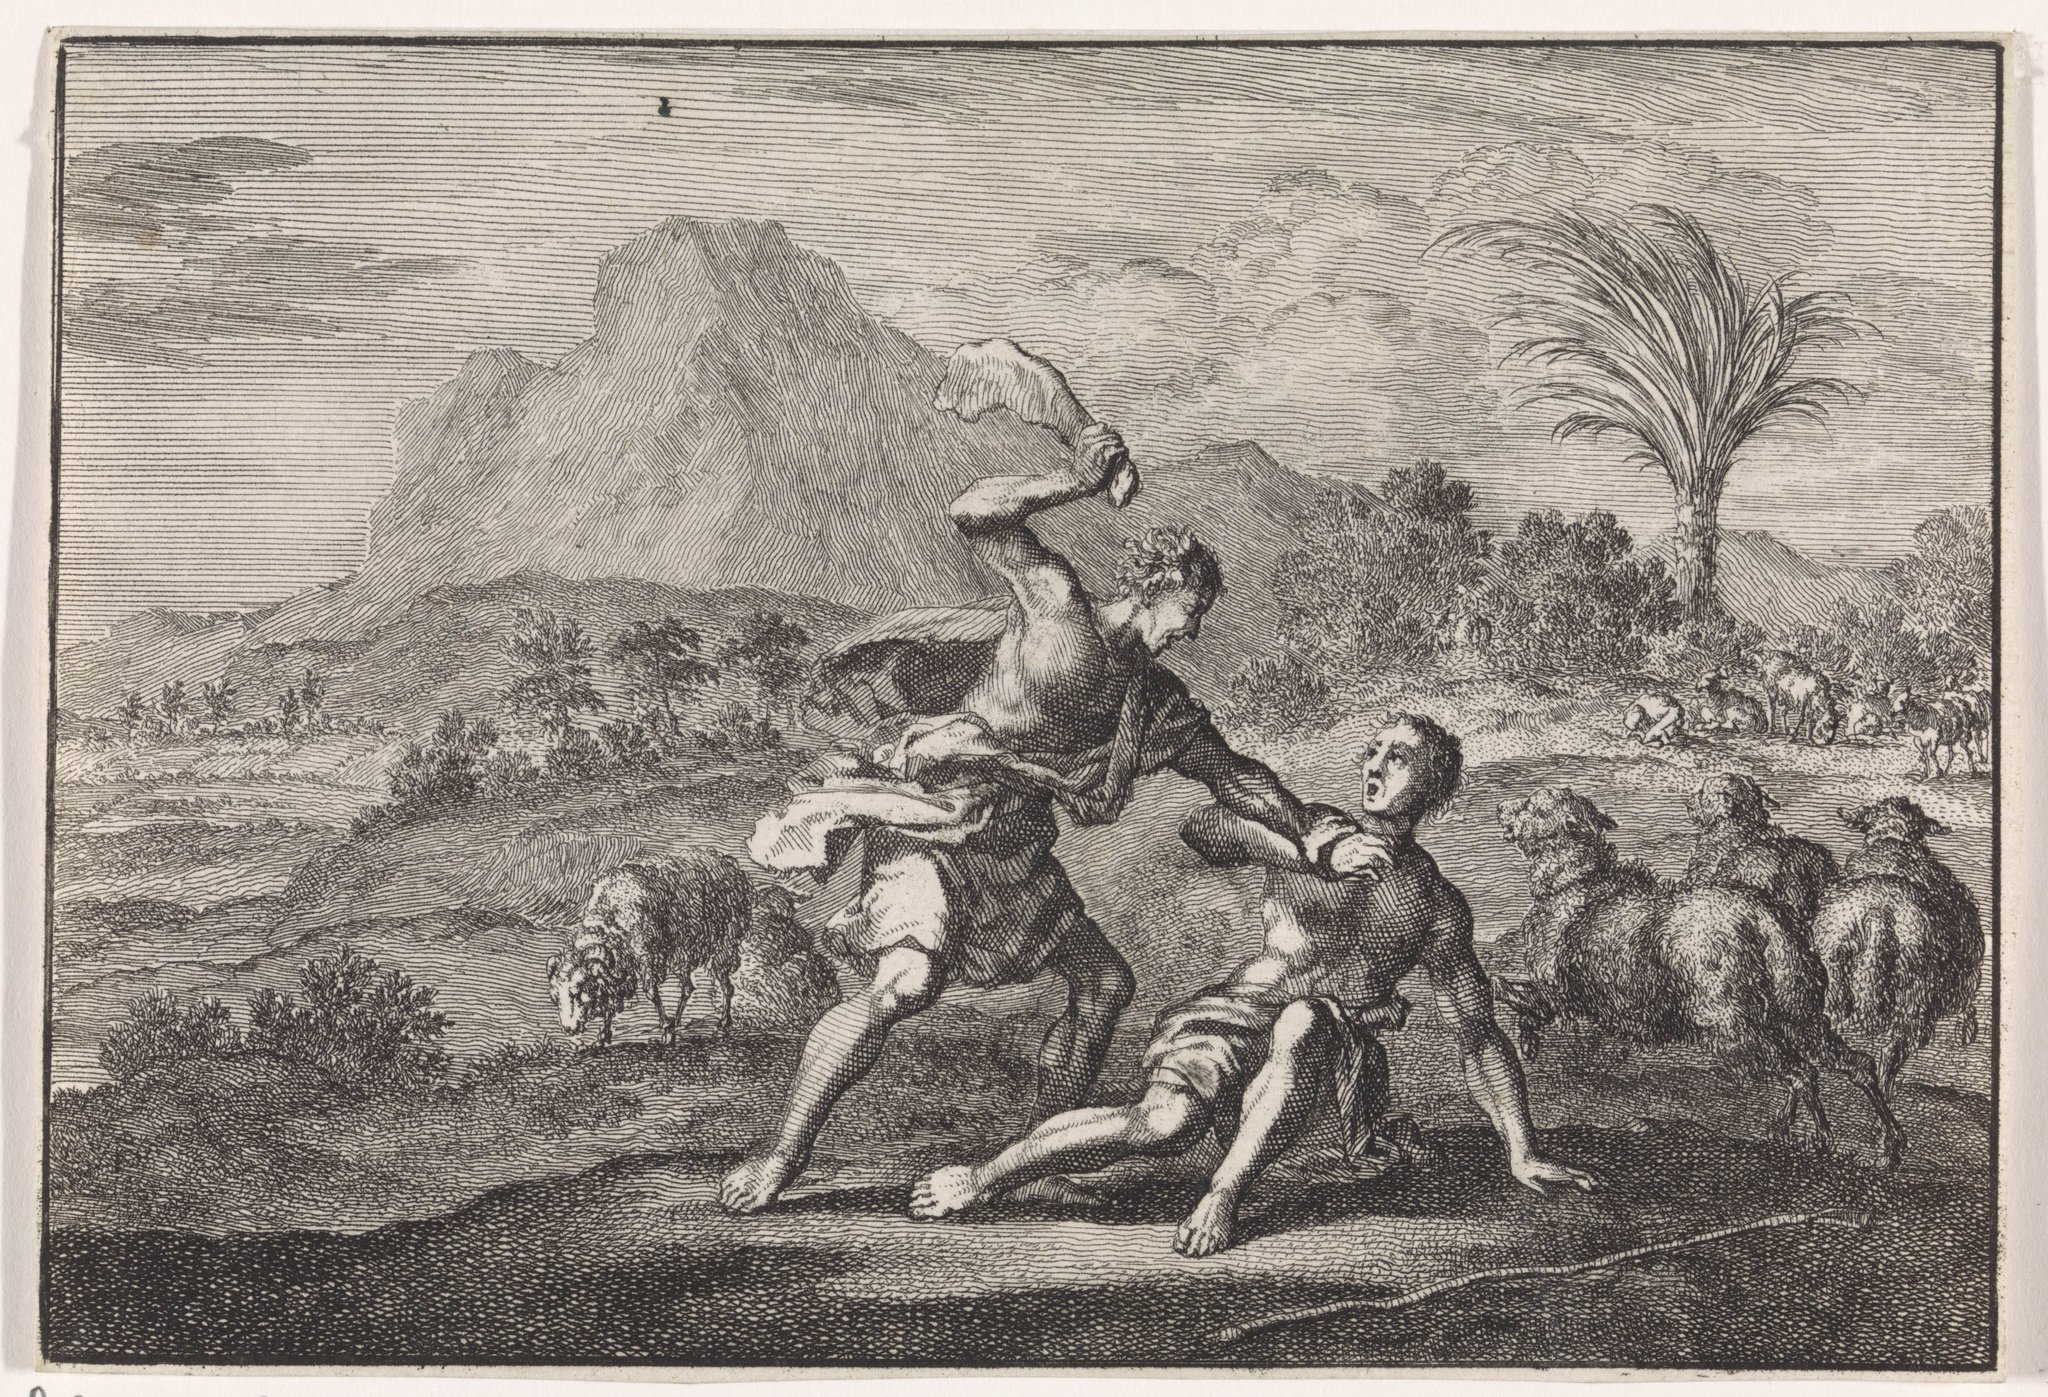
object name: print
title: Kaïn doodt Abel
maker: jan luyken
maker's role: draughtsman, print maker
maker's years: 1649-1712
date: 1703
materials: paper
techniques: etching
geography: amsterdam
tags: the killing of abel: cain slays him with a stone, a club or a jaw-bone, alternatively with a spade or another tool as weapon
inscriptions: collector's mark: Lugt 2228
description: Proefdruk van een boekillustratie voor David Martin. Historie des Ouden en Nieuwen Testaments. Amsterdam, Pieter Mortier, 1703. Deel I. De boekillustraties voor de Mortierbijbel hebben verschillende staten en kopieën, waarbij de chronologische volgorde moeilijk te achterhalen valt. Als boekillustraties werden ze bovendien herhaaldelijk opnieuw gebruikt voor andere boekwerken.